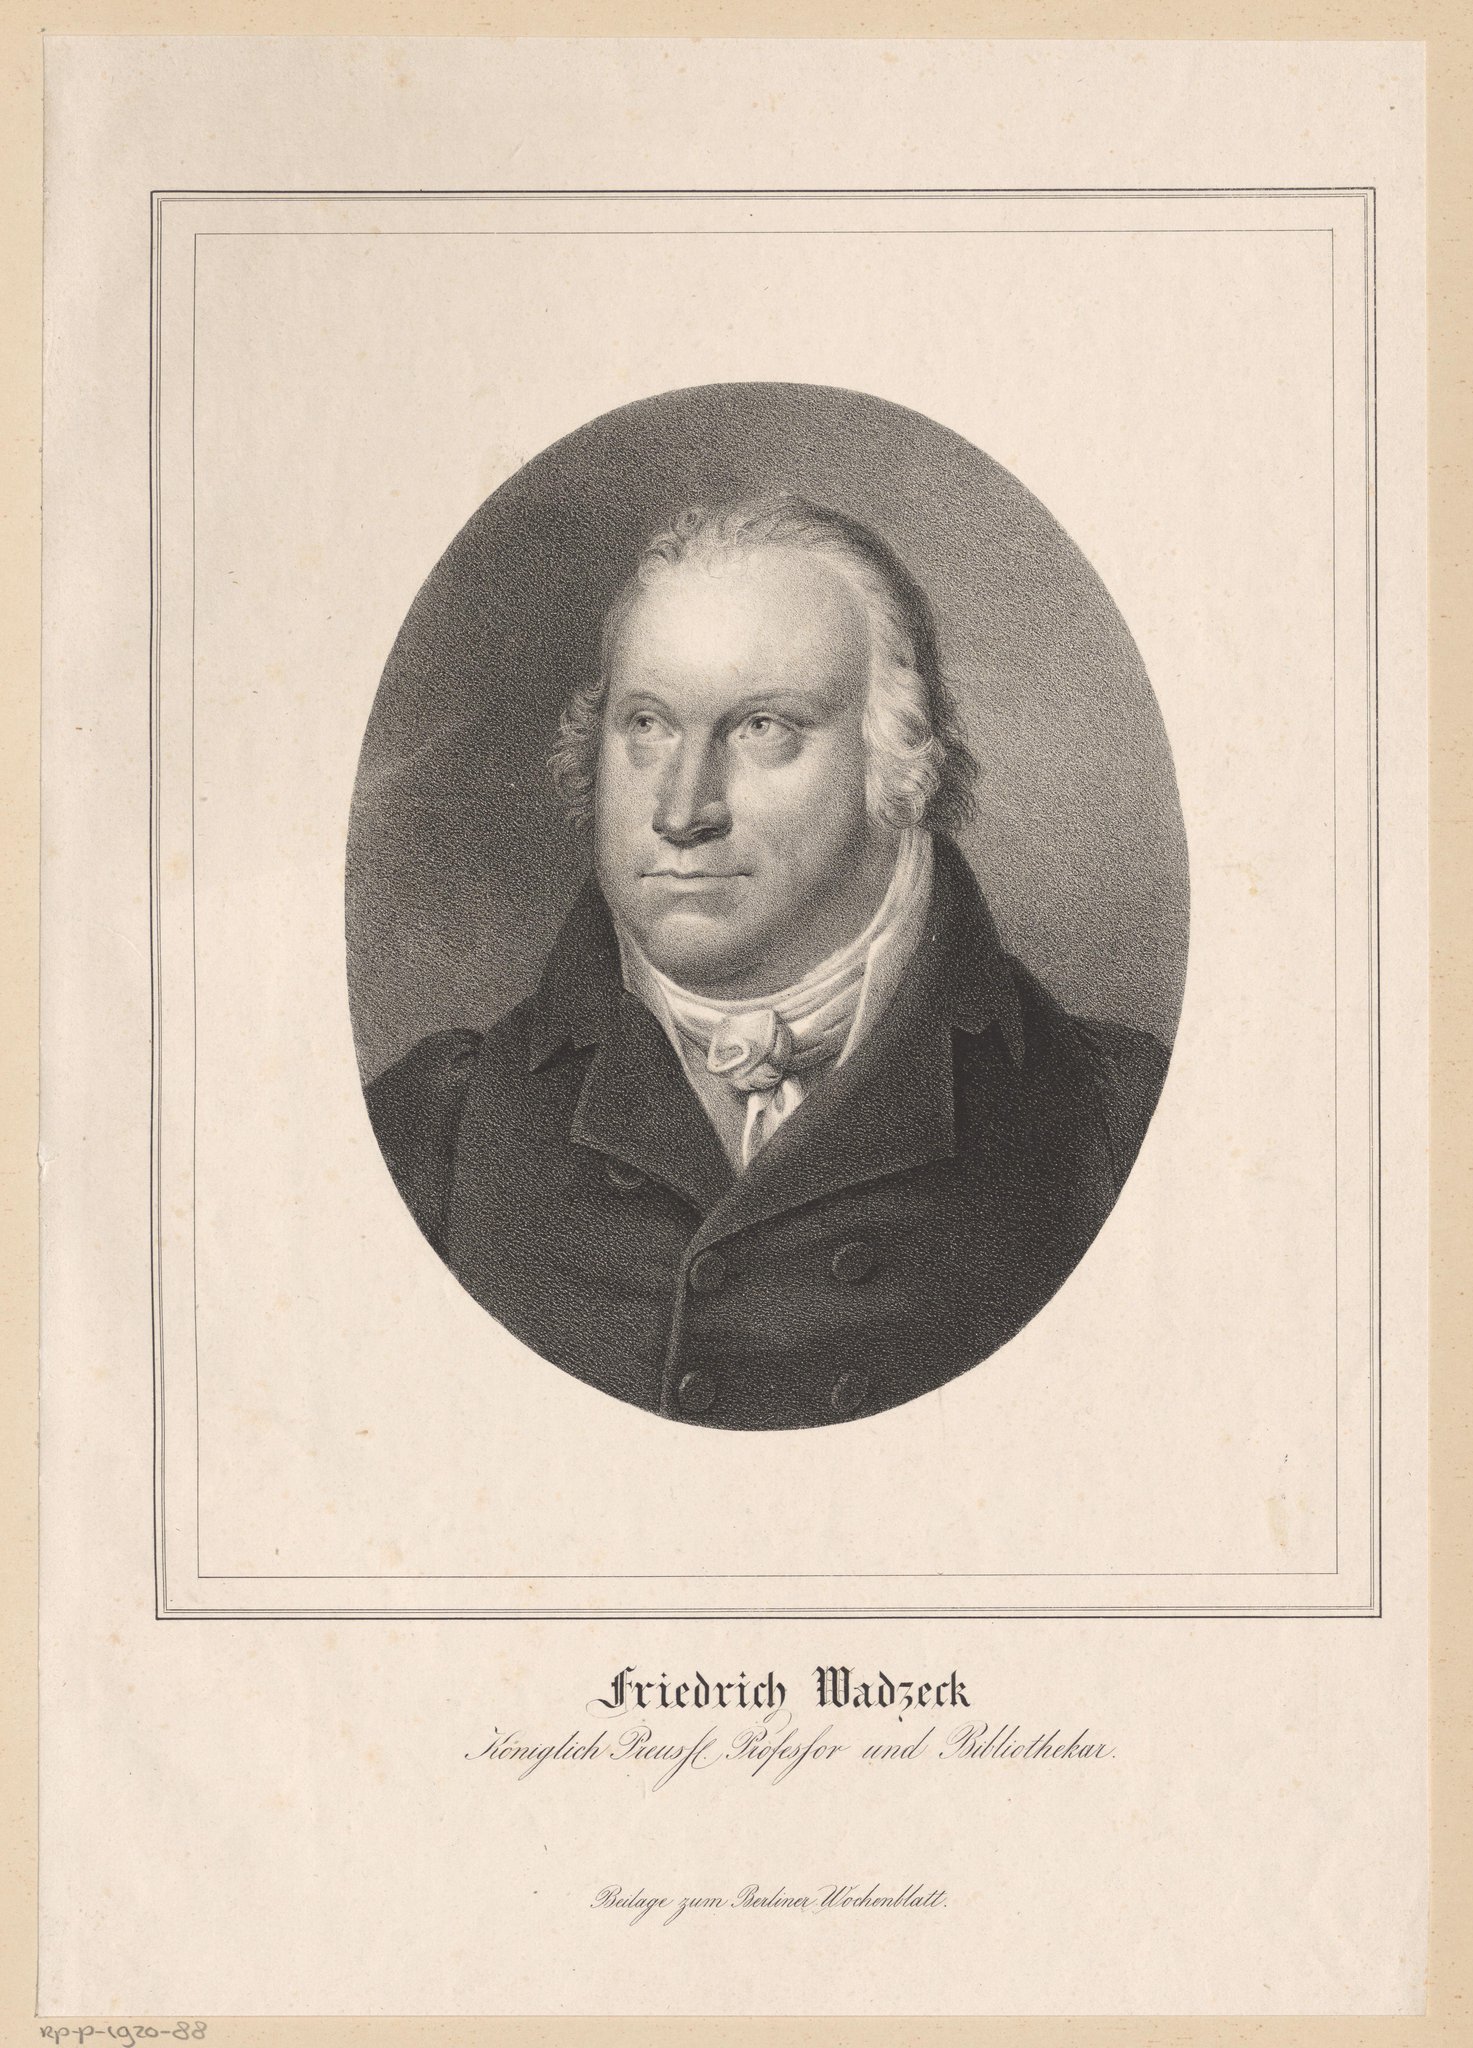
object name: print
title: Portret van Friedrich Wadzeck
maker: Anonymous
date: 1809-1820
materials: paper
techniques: lithograph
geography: germany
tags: berlin, theologian, historical persons, professor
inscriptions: collector's mark: Lugt 2228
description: Prent uitgegeven als bijlage van het Berlinisches Wochenblatt (1809-1820).